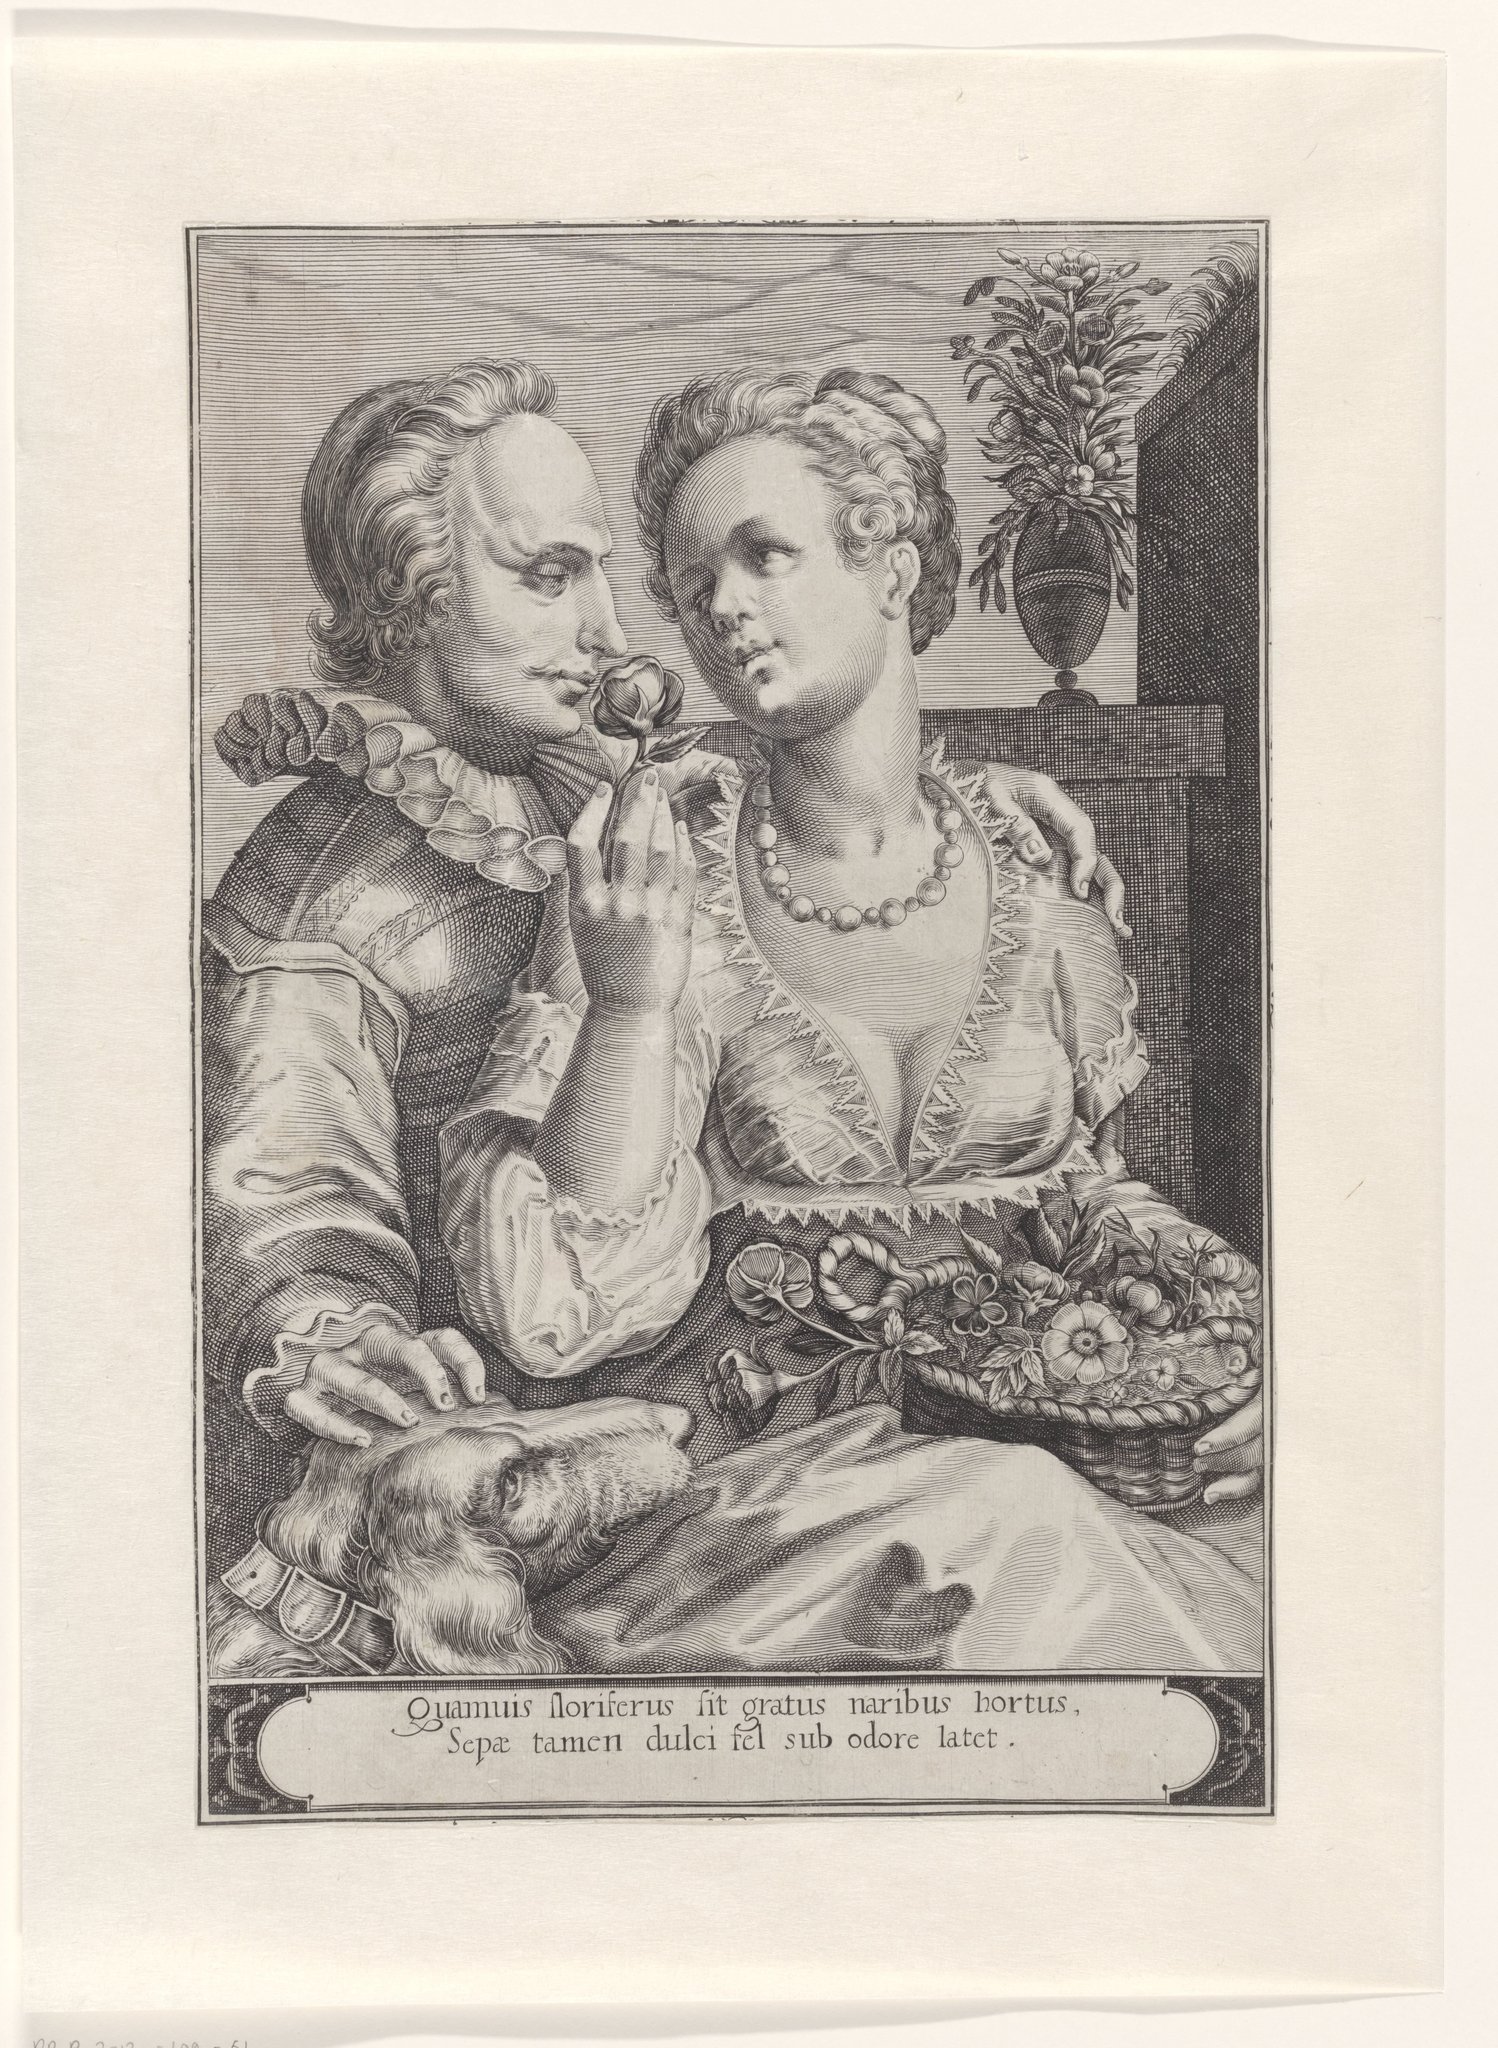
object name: print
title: Reuk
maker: johannes eillarts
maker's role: print maker, publisher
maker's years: 1568-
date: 1578-1678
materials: paper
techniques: engraving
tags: smell, smelling (one of the five senses)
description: Een man en een vrouw, ruikend aan een bloem. Op de schoot van de vrouw een mand bloemen. De hand van de man ligt op de kop van een hond (bekend om zijn goede reukzin) . Allegorie van de Reuk, een van de vijf zintuigen. Vergrote kopie naar gravure Jan Saenredam naar Hendrick Goltzius.